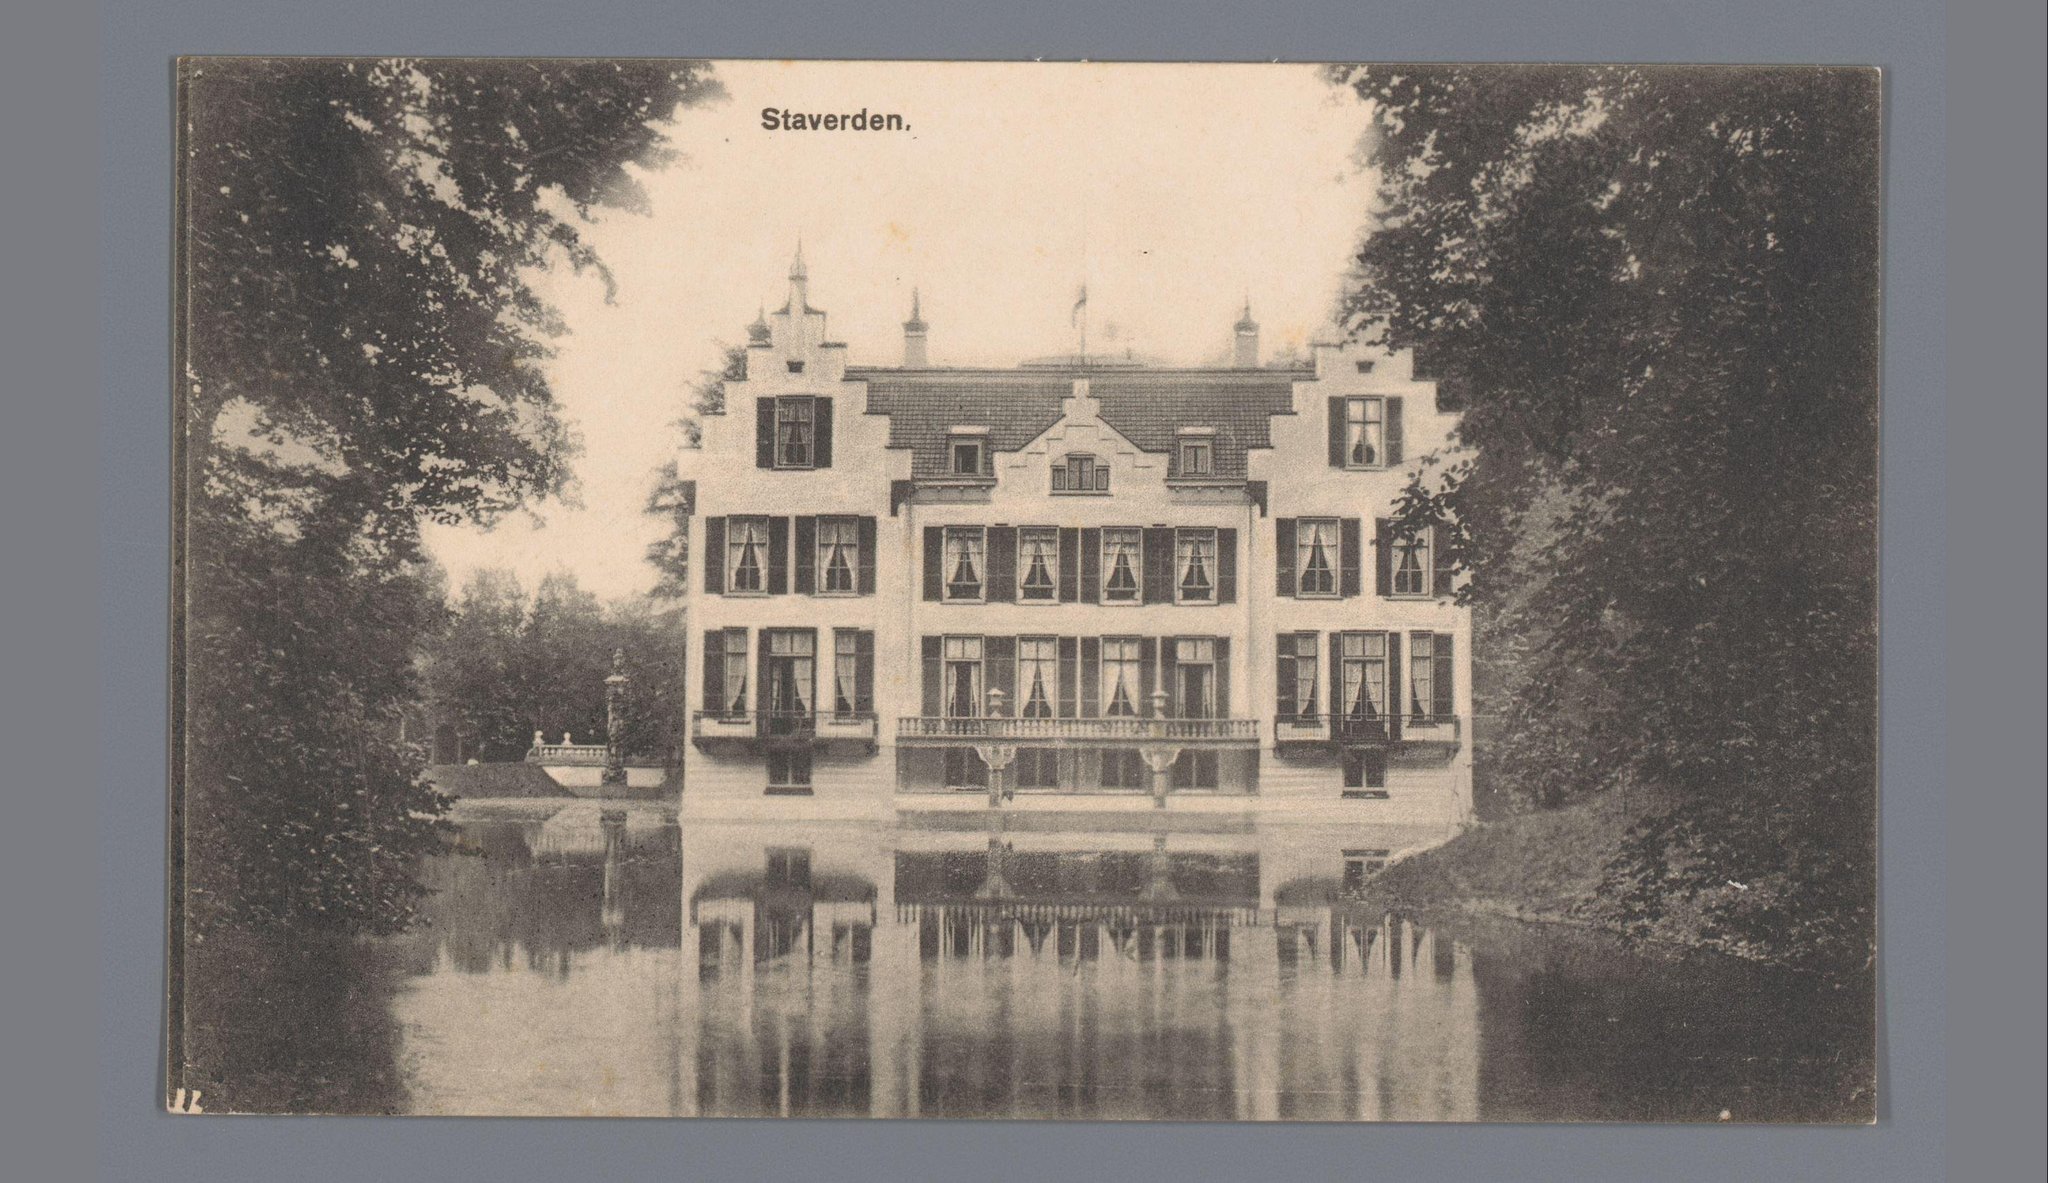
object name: photomechanical print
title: Landhuis Staverden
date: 1880-1910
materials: paper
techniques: photograph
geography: staverden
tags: rural housing, e.g. country-house, villa, cottage, façade (of house or building)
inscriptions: workshop stamp: ‘Phot. v. M.C. Termaat, Nijmegen. Nadruk verboden.’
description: Op verso regels om te versturen als postkaart.